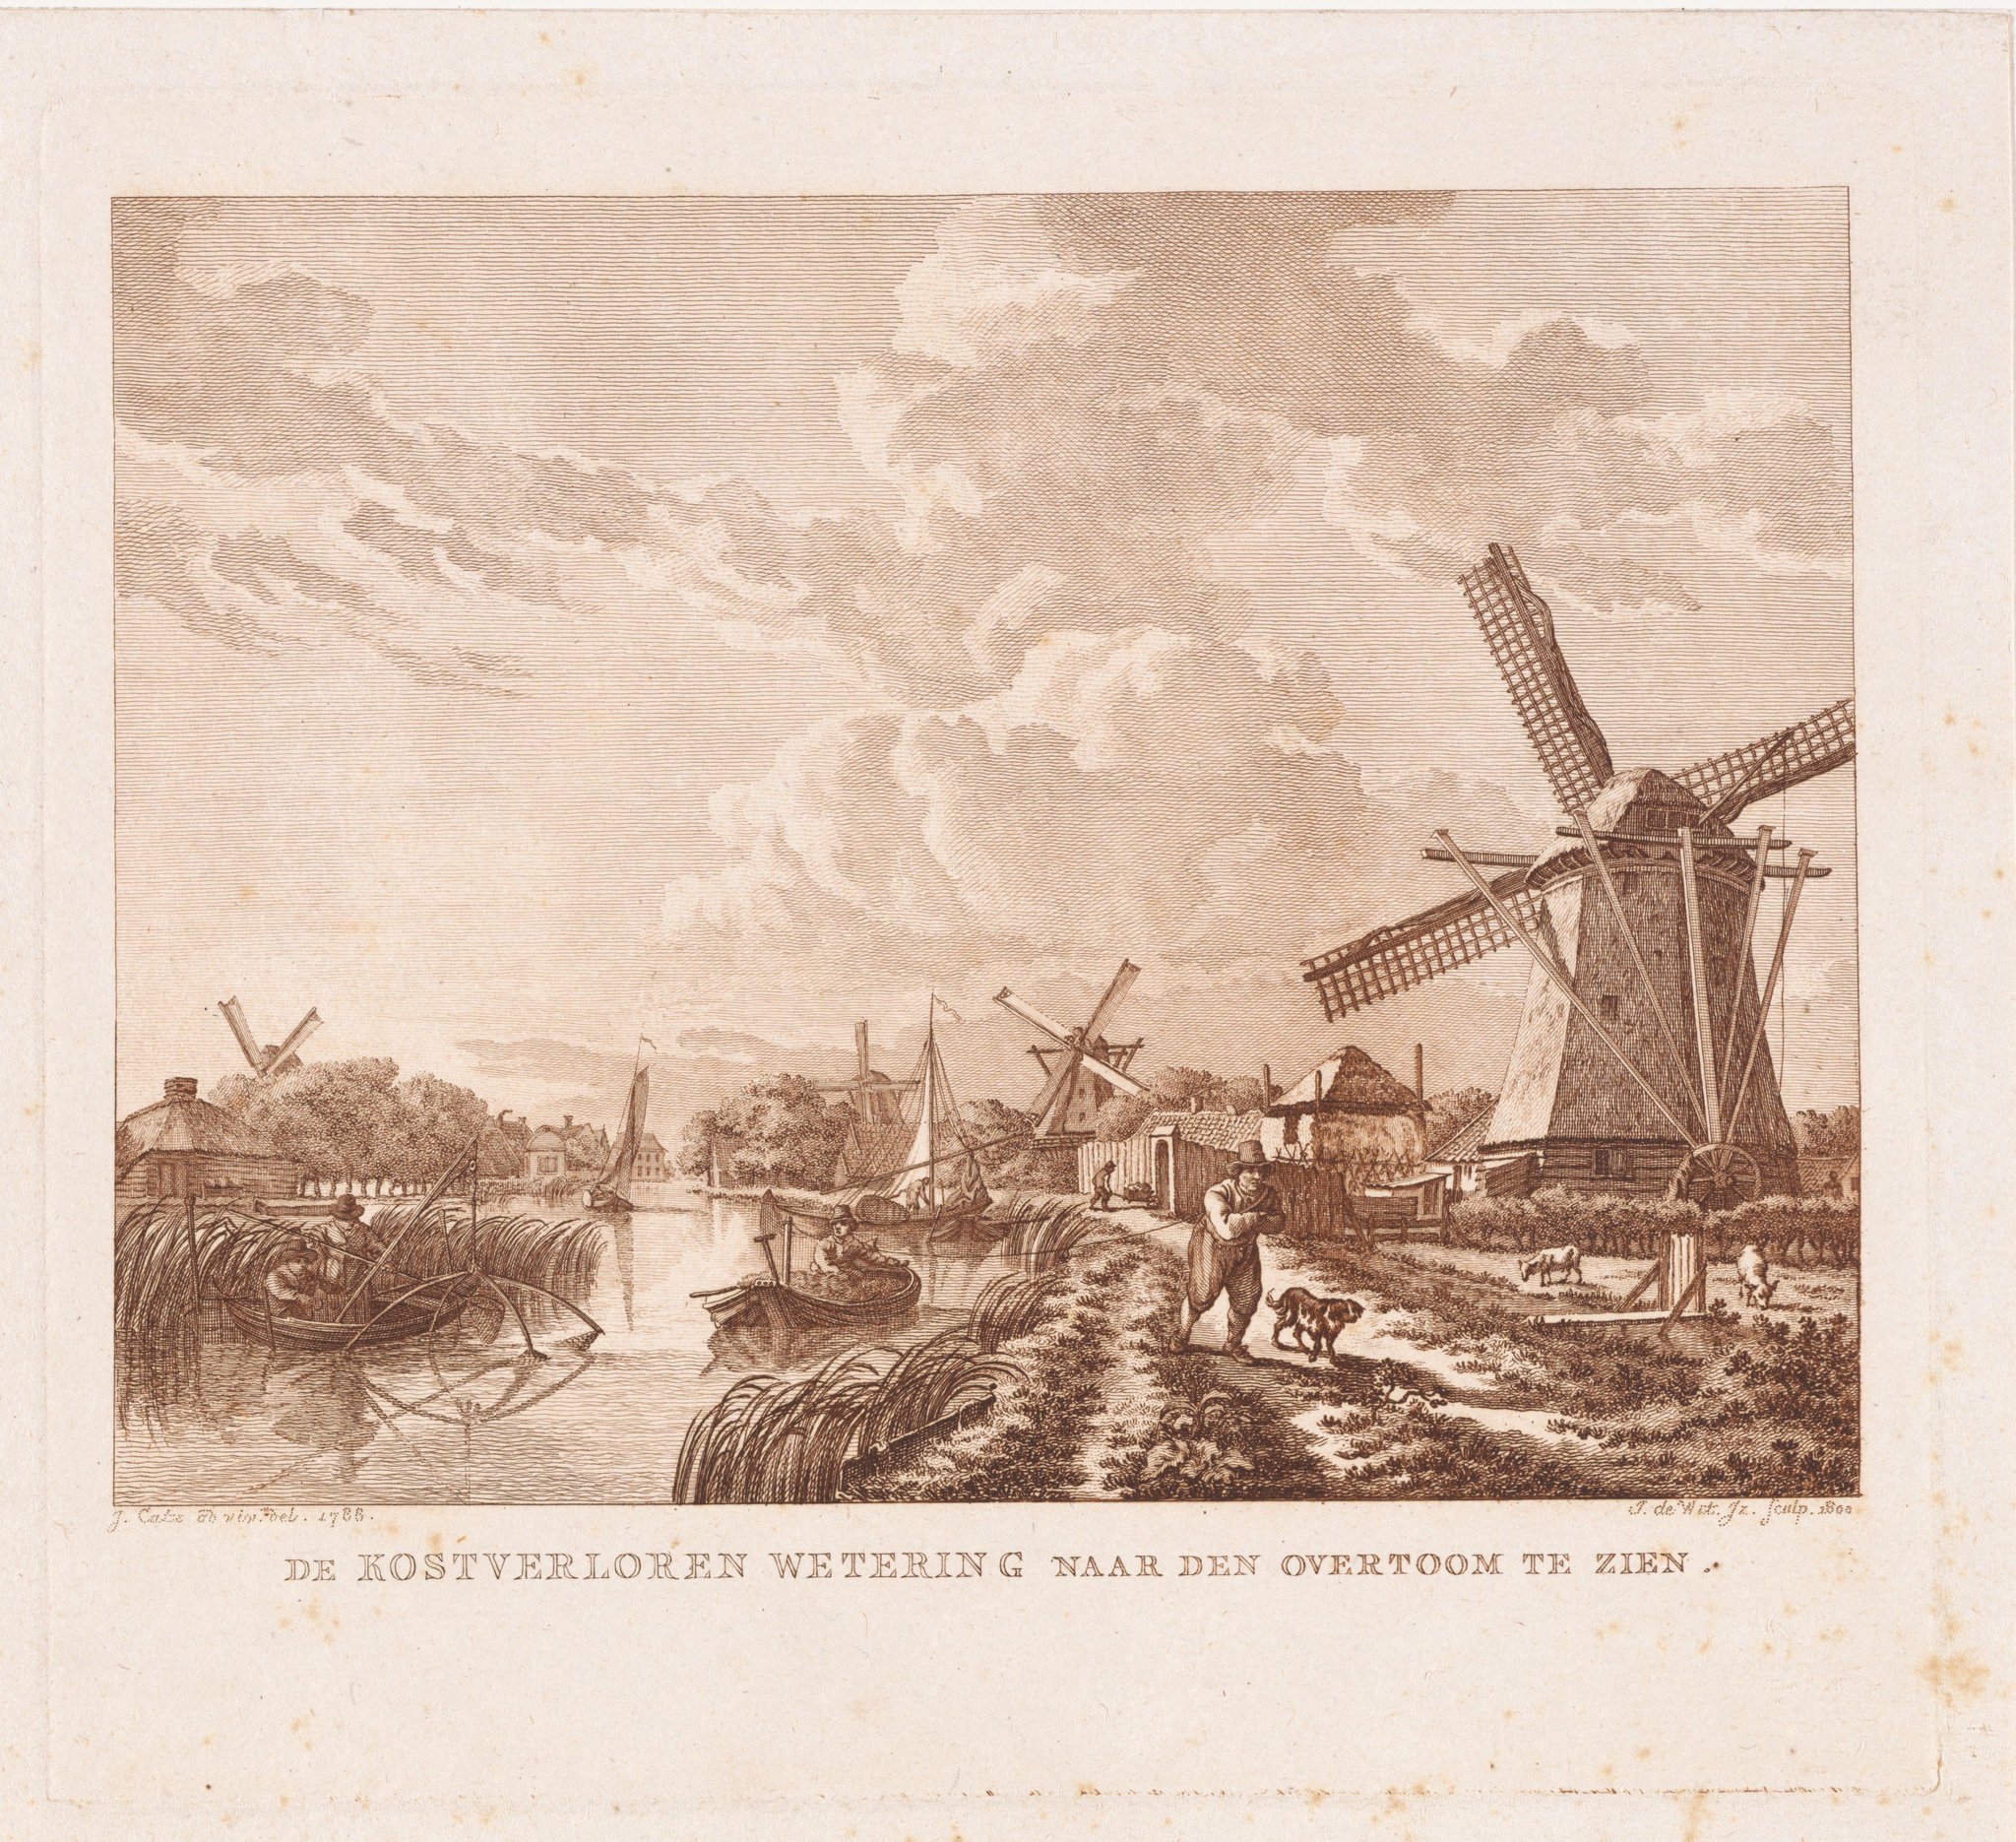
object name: print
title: Trekschuit en vissers op een rivier langs molens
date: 1800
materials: paper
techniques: etching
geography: haarlem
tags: windmill in landscape, tow-boat, towing-barge, towing path, fisherman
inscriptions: collector's mark: Lugt 2228